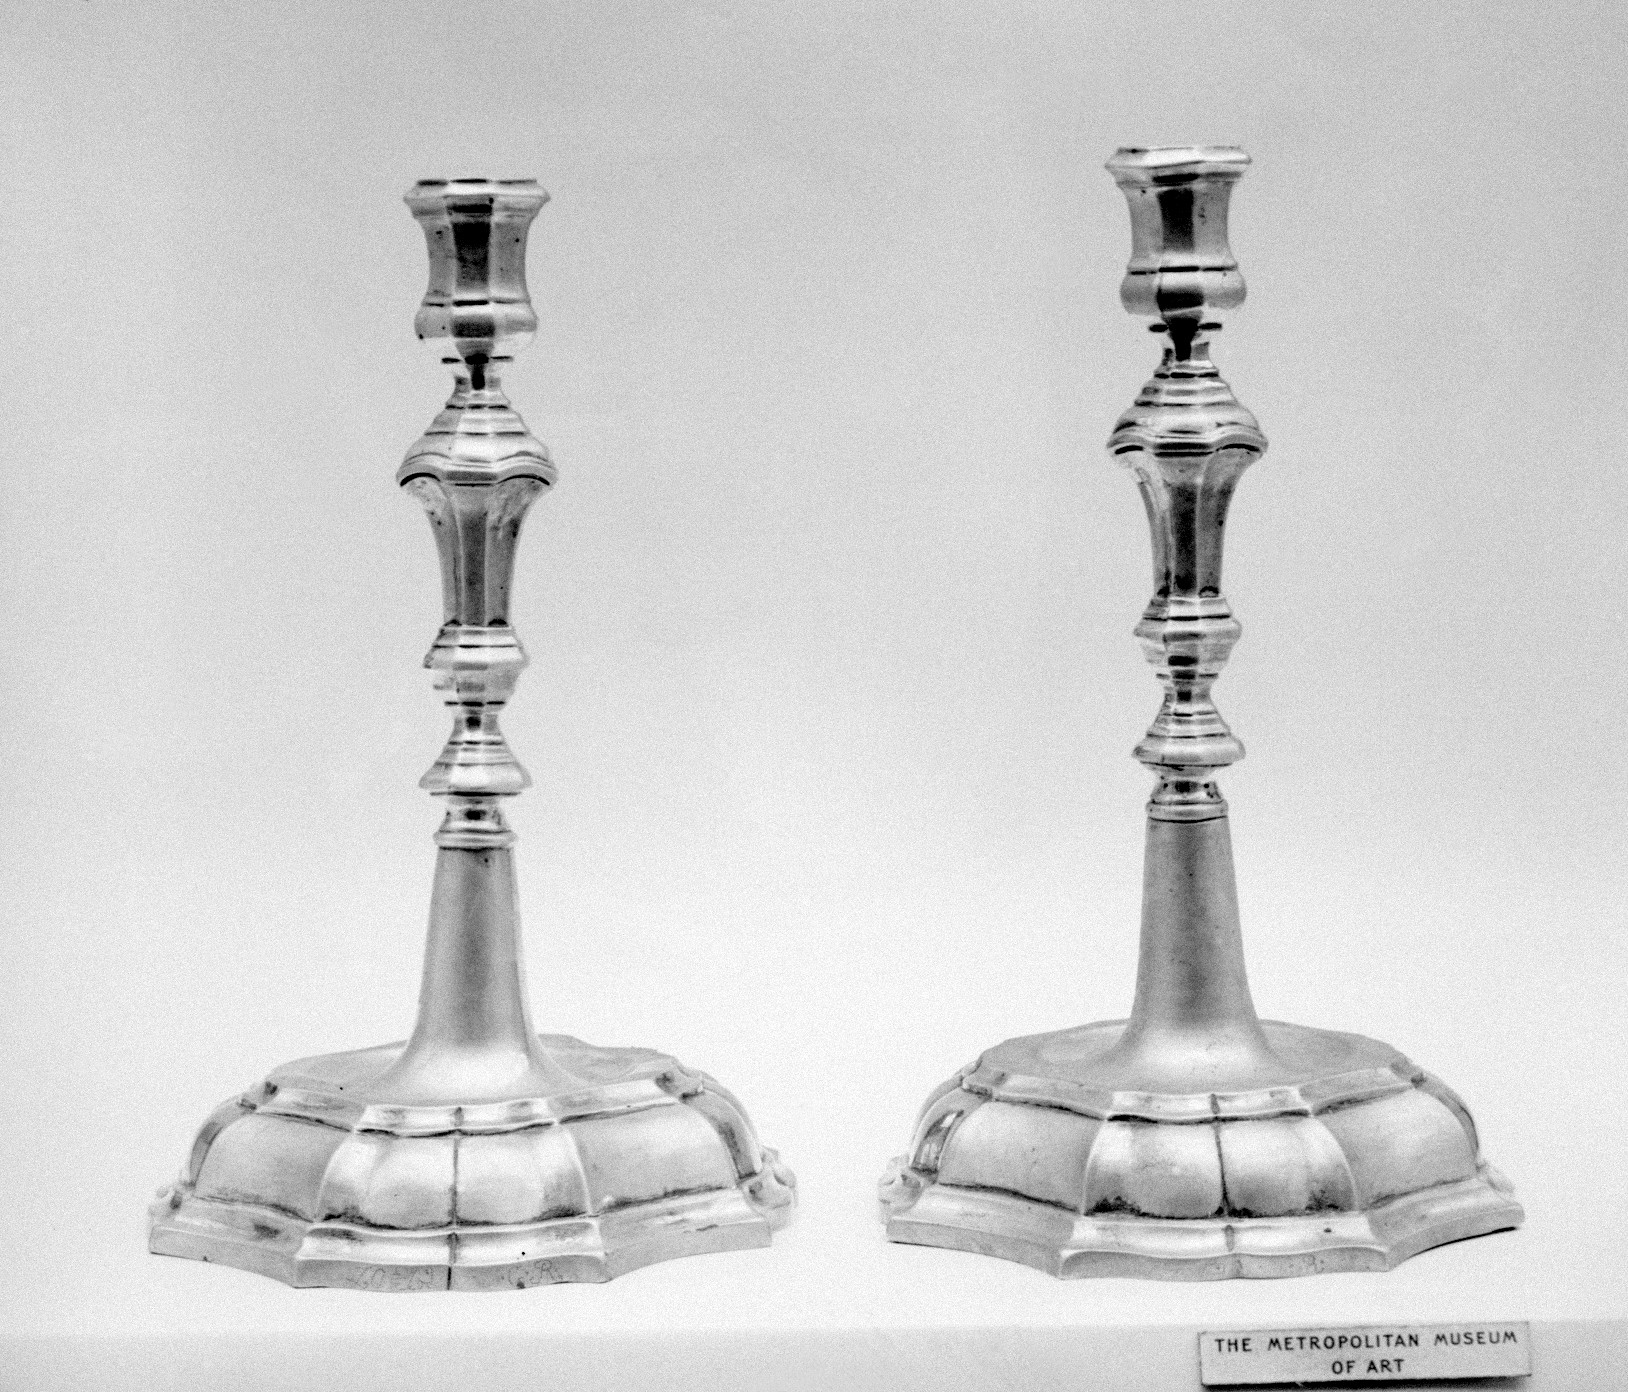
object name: candlestick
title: Candlestick (one of a pair)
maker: johan jorgen schowert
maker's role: maker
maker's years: 1738-1755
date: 1701-1800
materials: silver